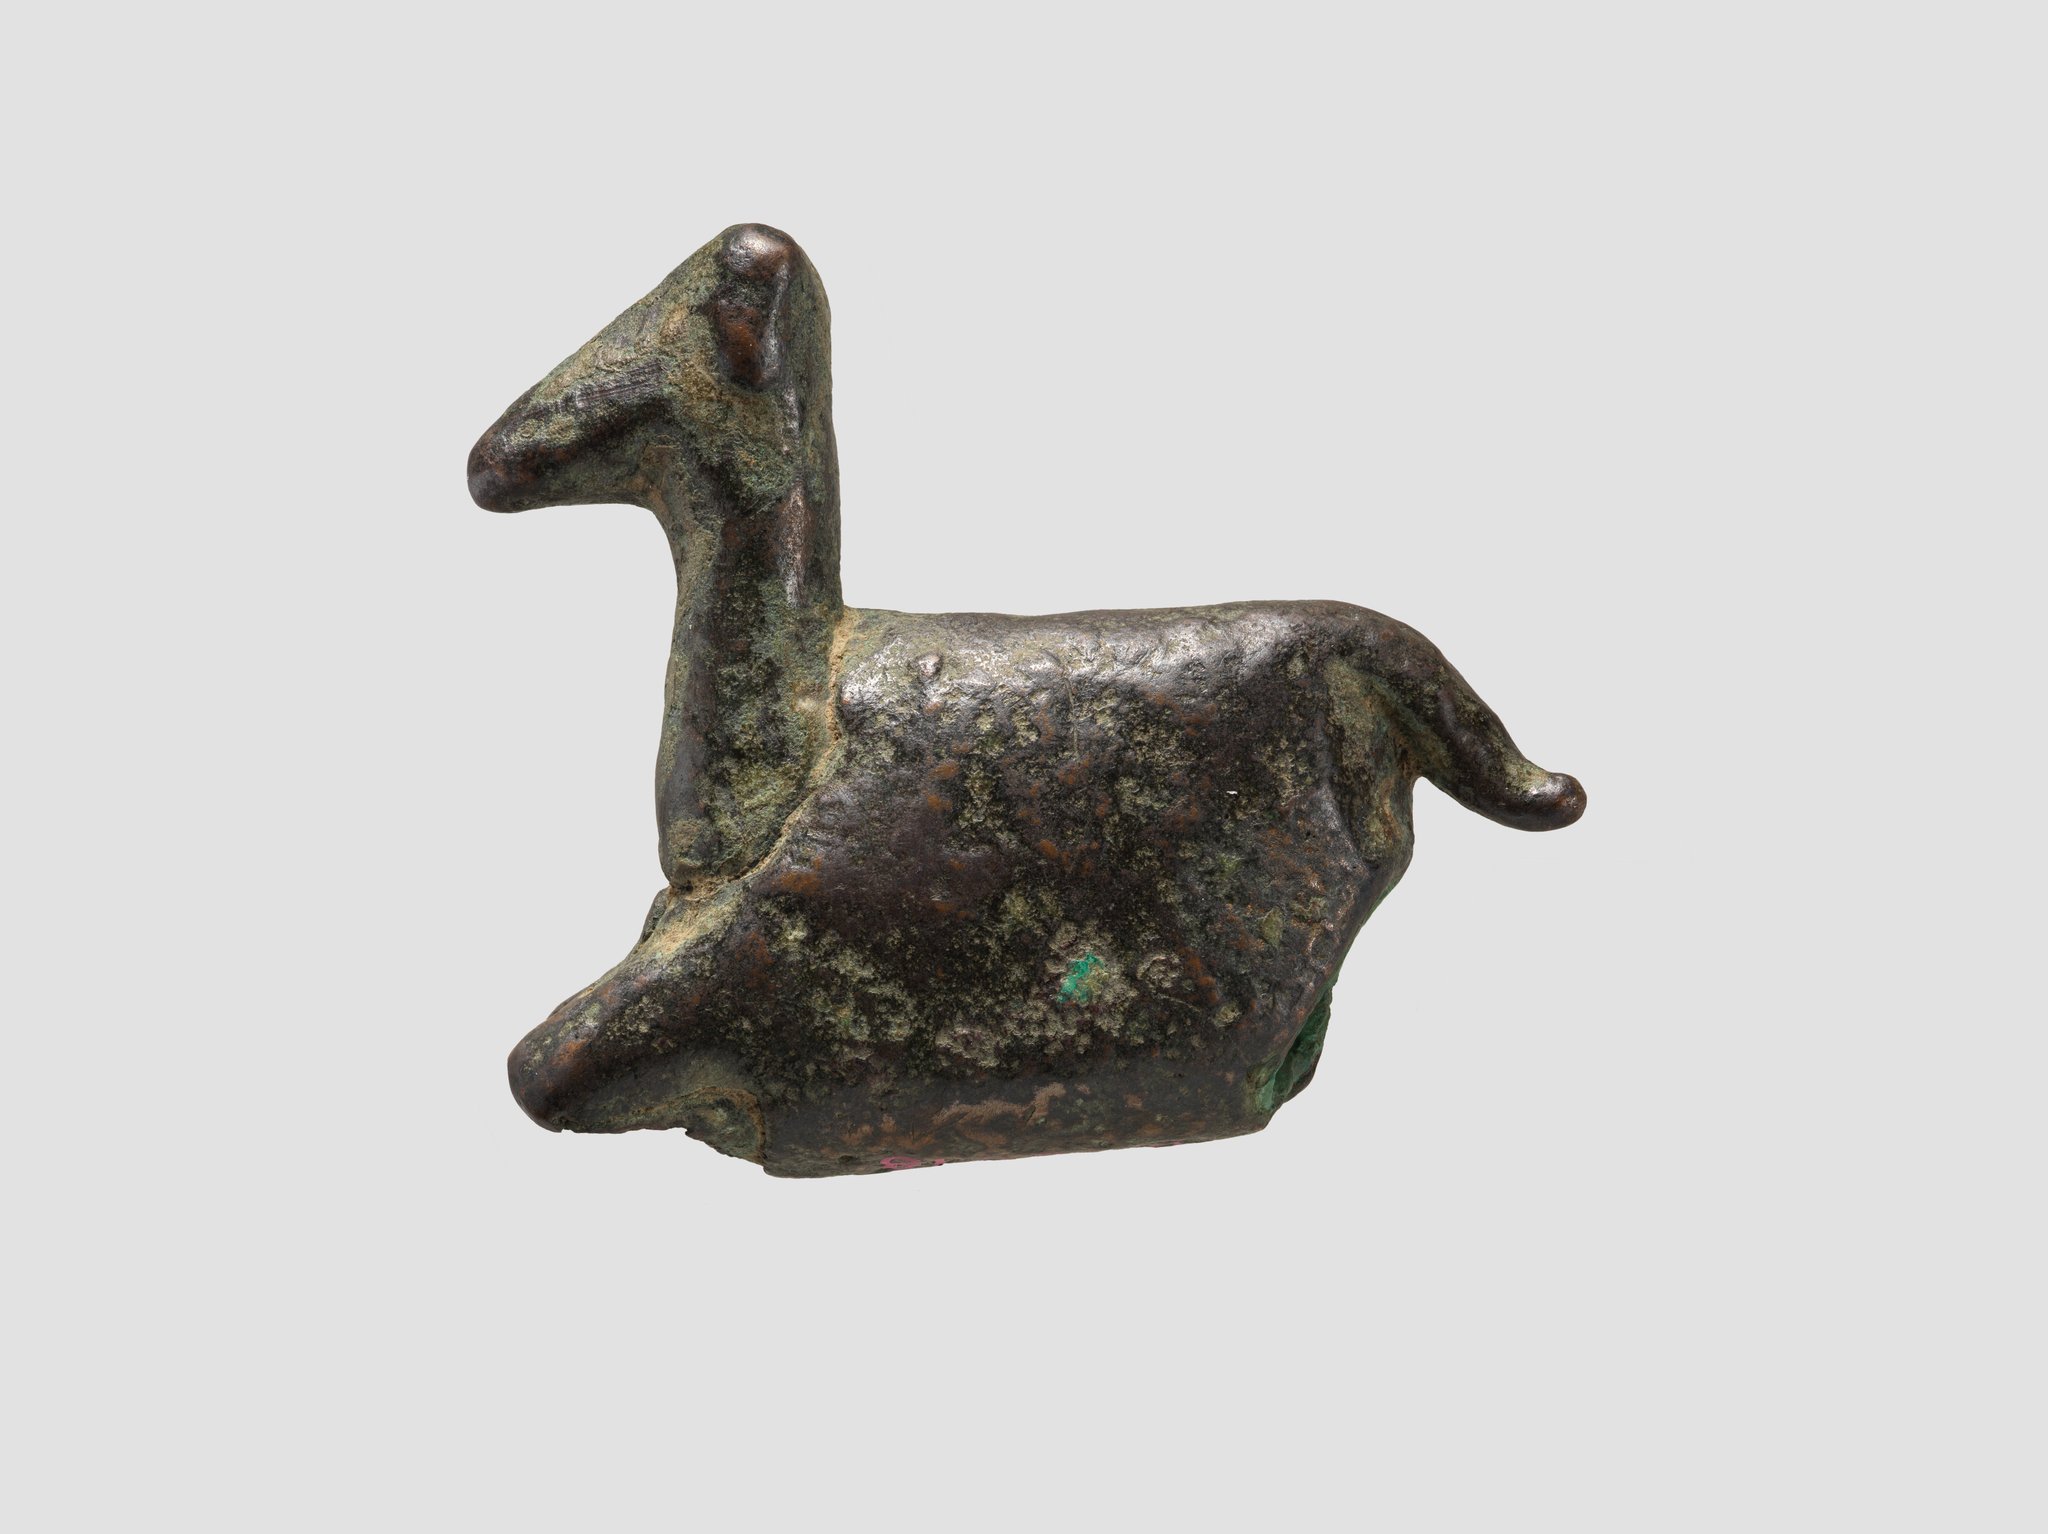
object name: ornament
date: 668-1000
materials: bronze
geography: anatolia (?)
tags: animals